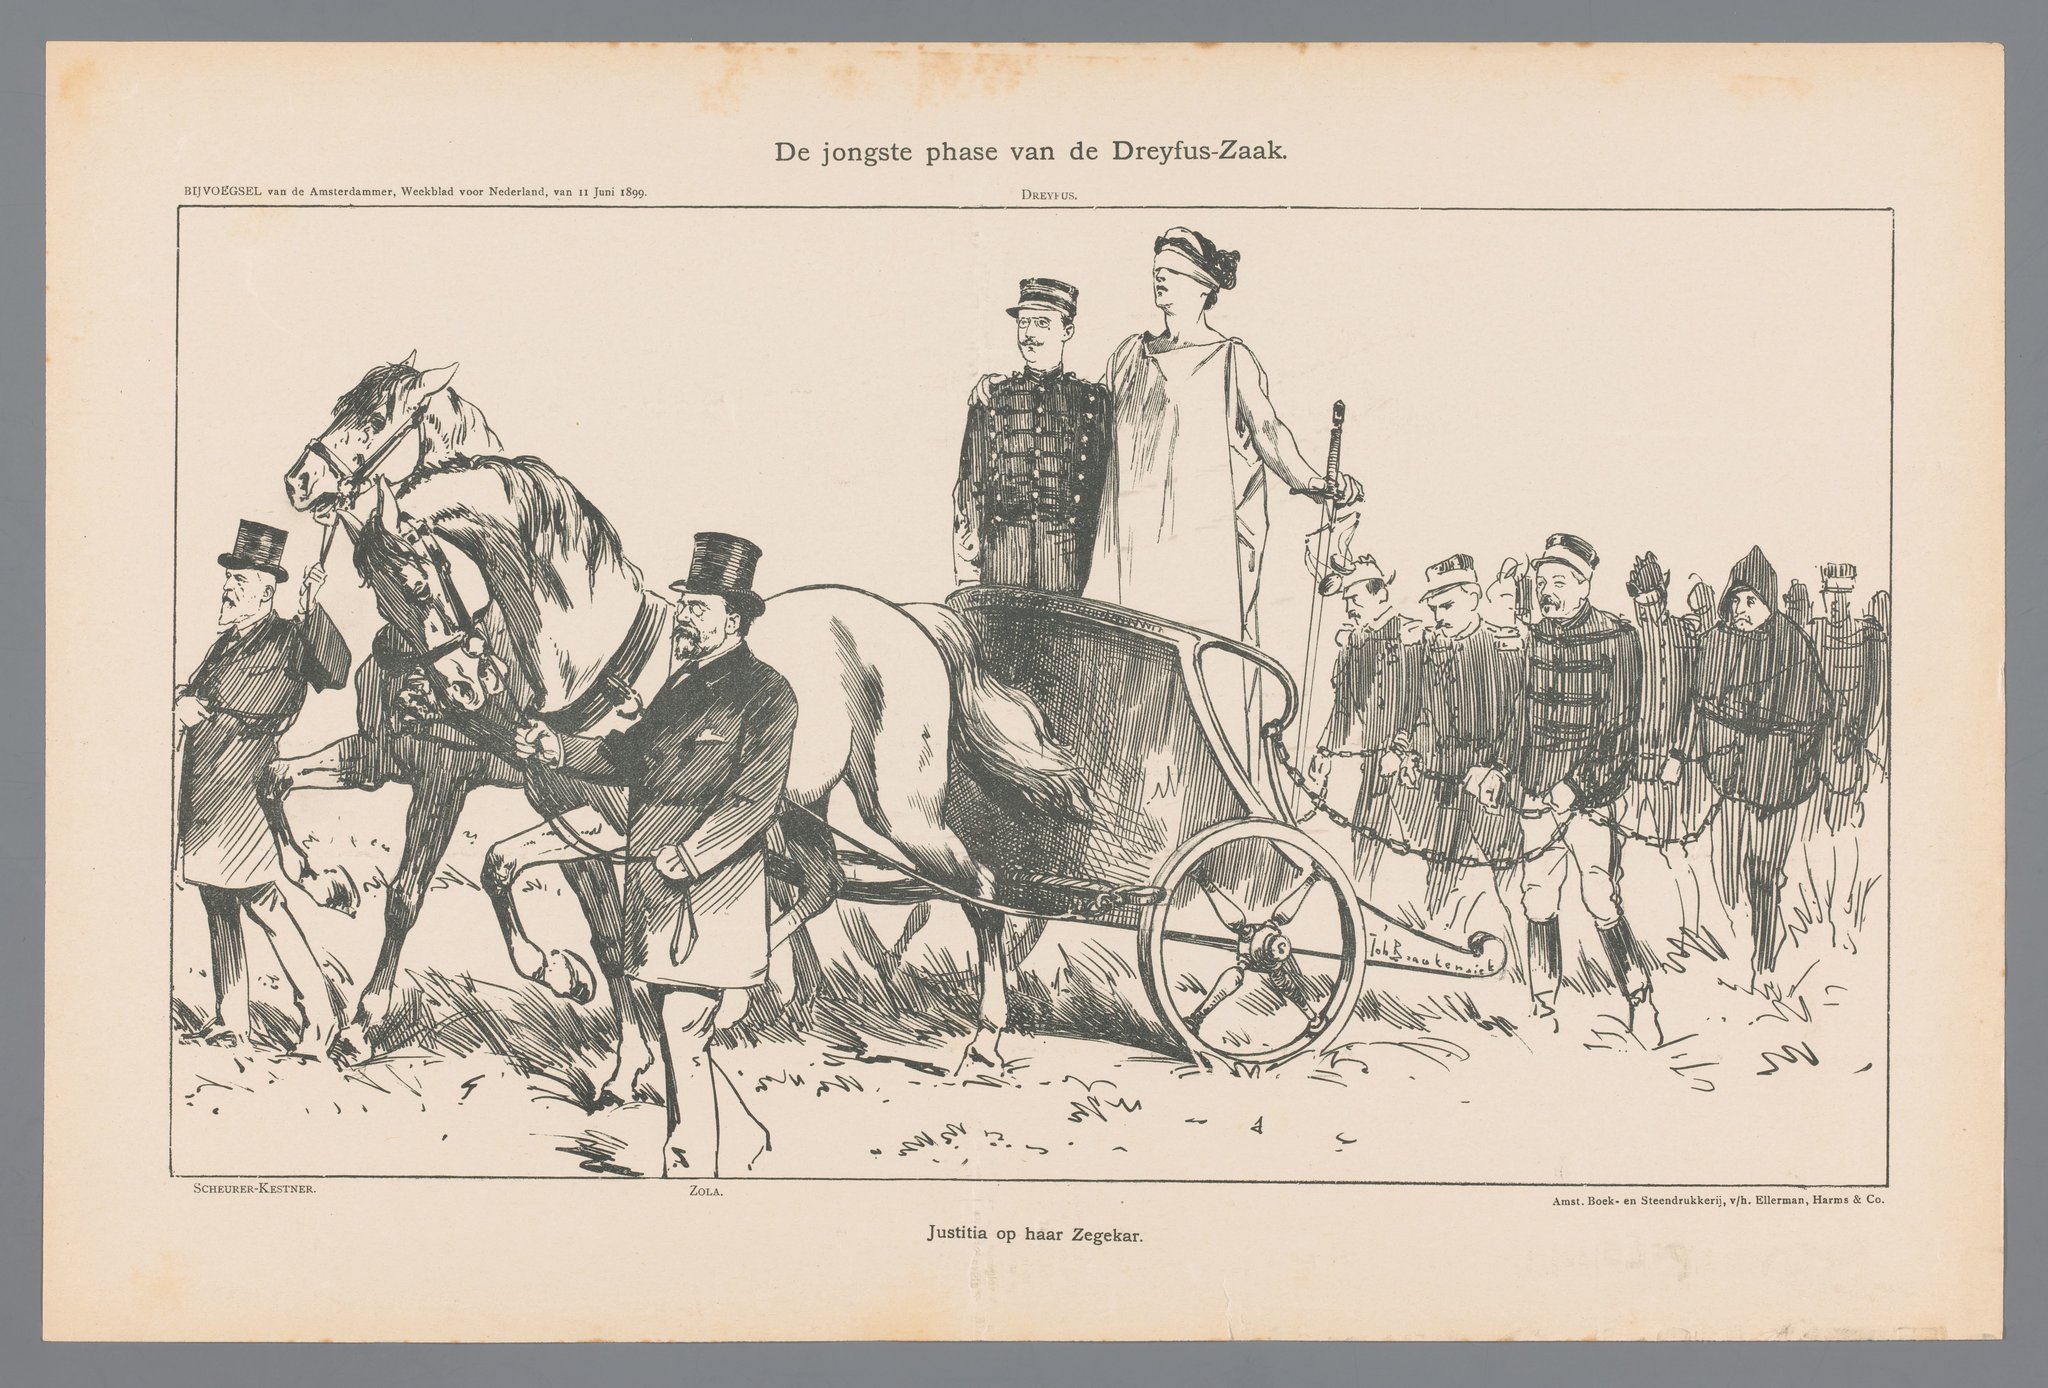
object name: cartoon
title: De jongste phase van de Dreyfus-Zaak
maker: johan braakensiek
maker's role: draughtsman, print maker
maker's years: 1858-1940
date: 1899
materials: paper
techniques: lithograph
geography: amsterdam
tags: emile zola, paris, historical persons, justitia (justice) as roman personification, political caricatures and satires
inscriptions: date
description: Prent uit het bijvoegsel van: De Amsterdammer. Weekblad voor Nederland, 11 juni 1899.